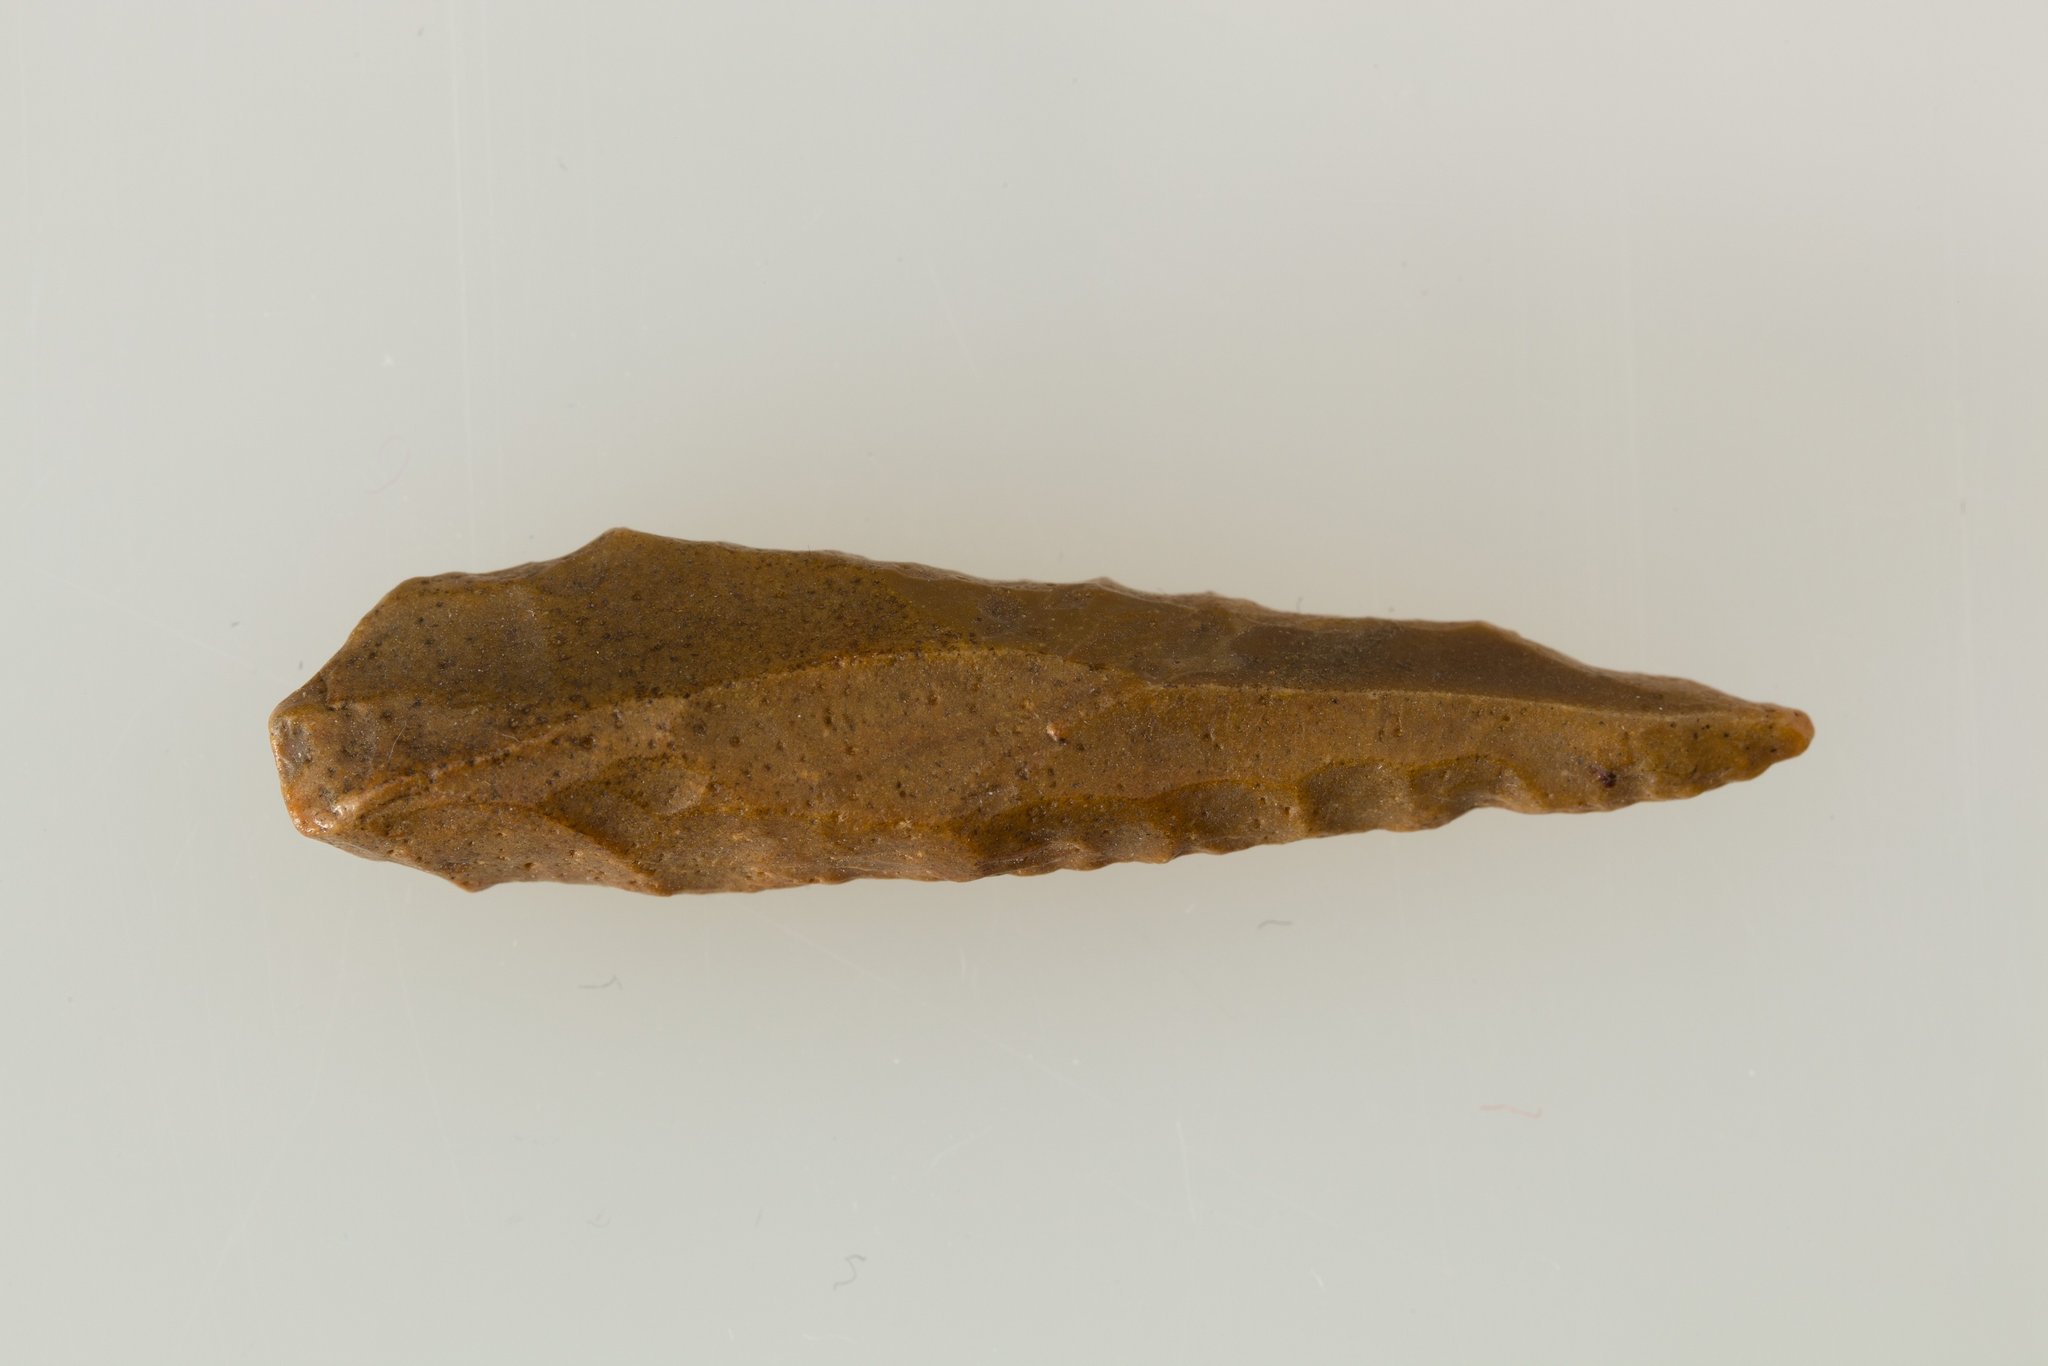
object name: tool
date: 3850-2960 BCE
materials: stone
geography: egypt